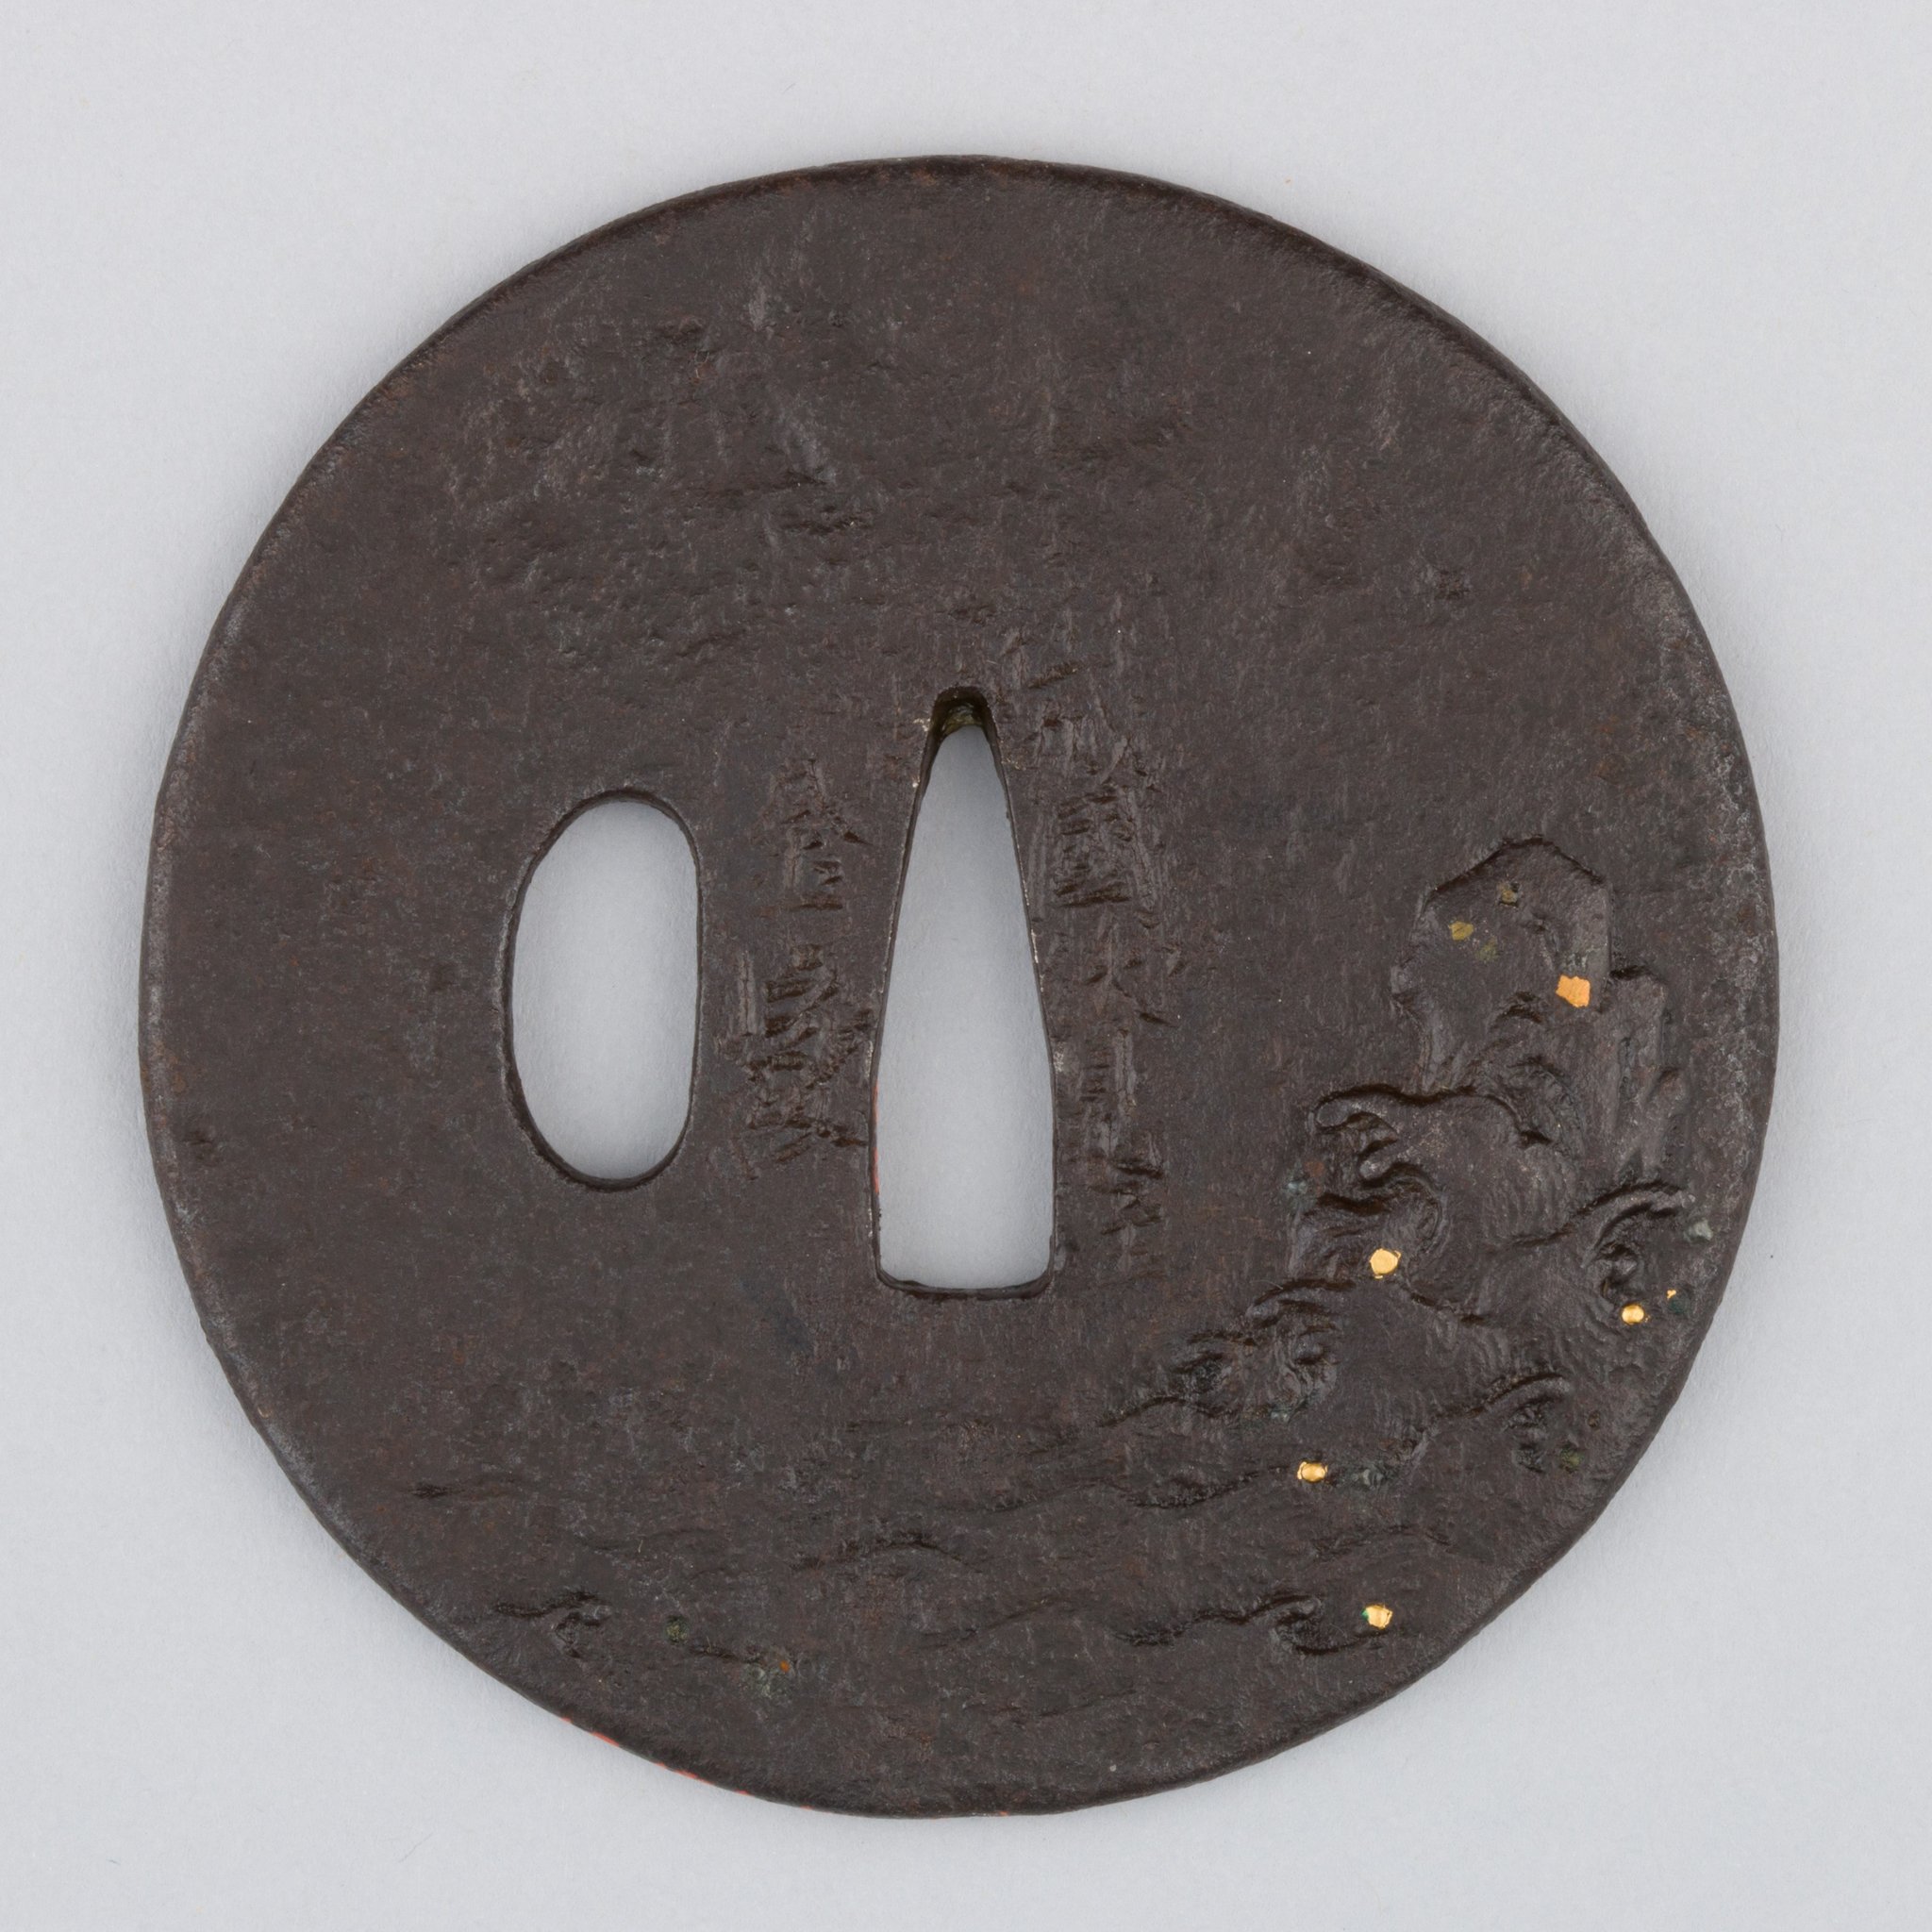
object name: sword guard tsuba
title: Sword Guard (Tsuba)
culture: japanese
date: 1615-1868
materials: copper, iron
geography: japan